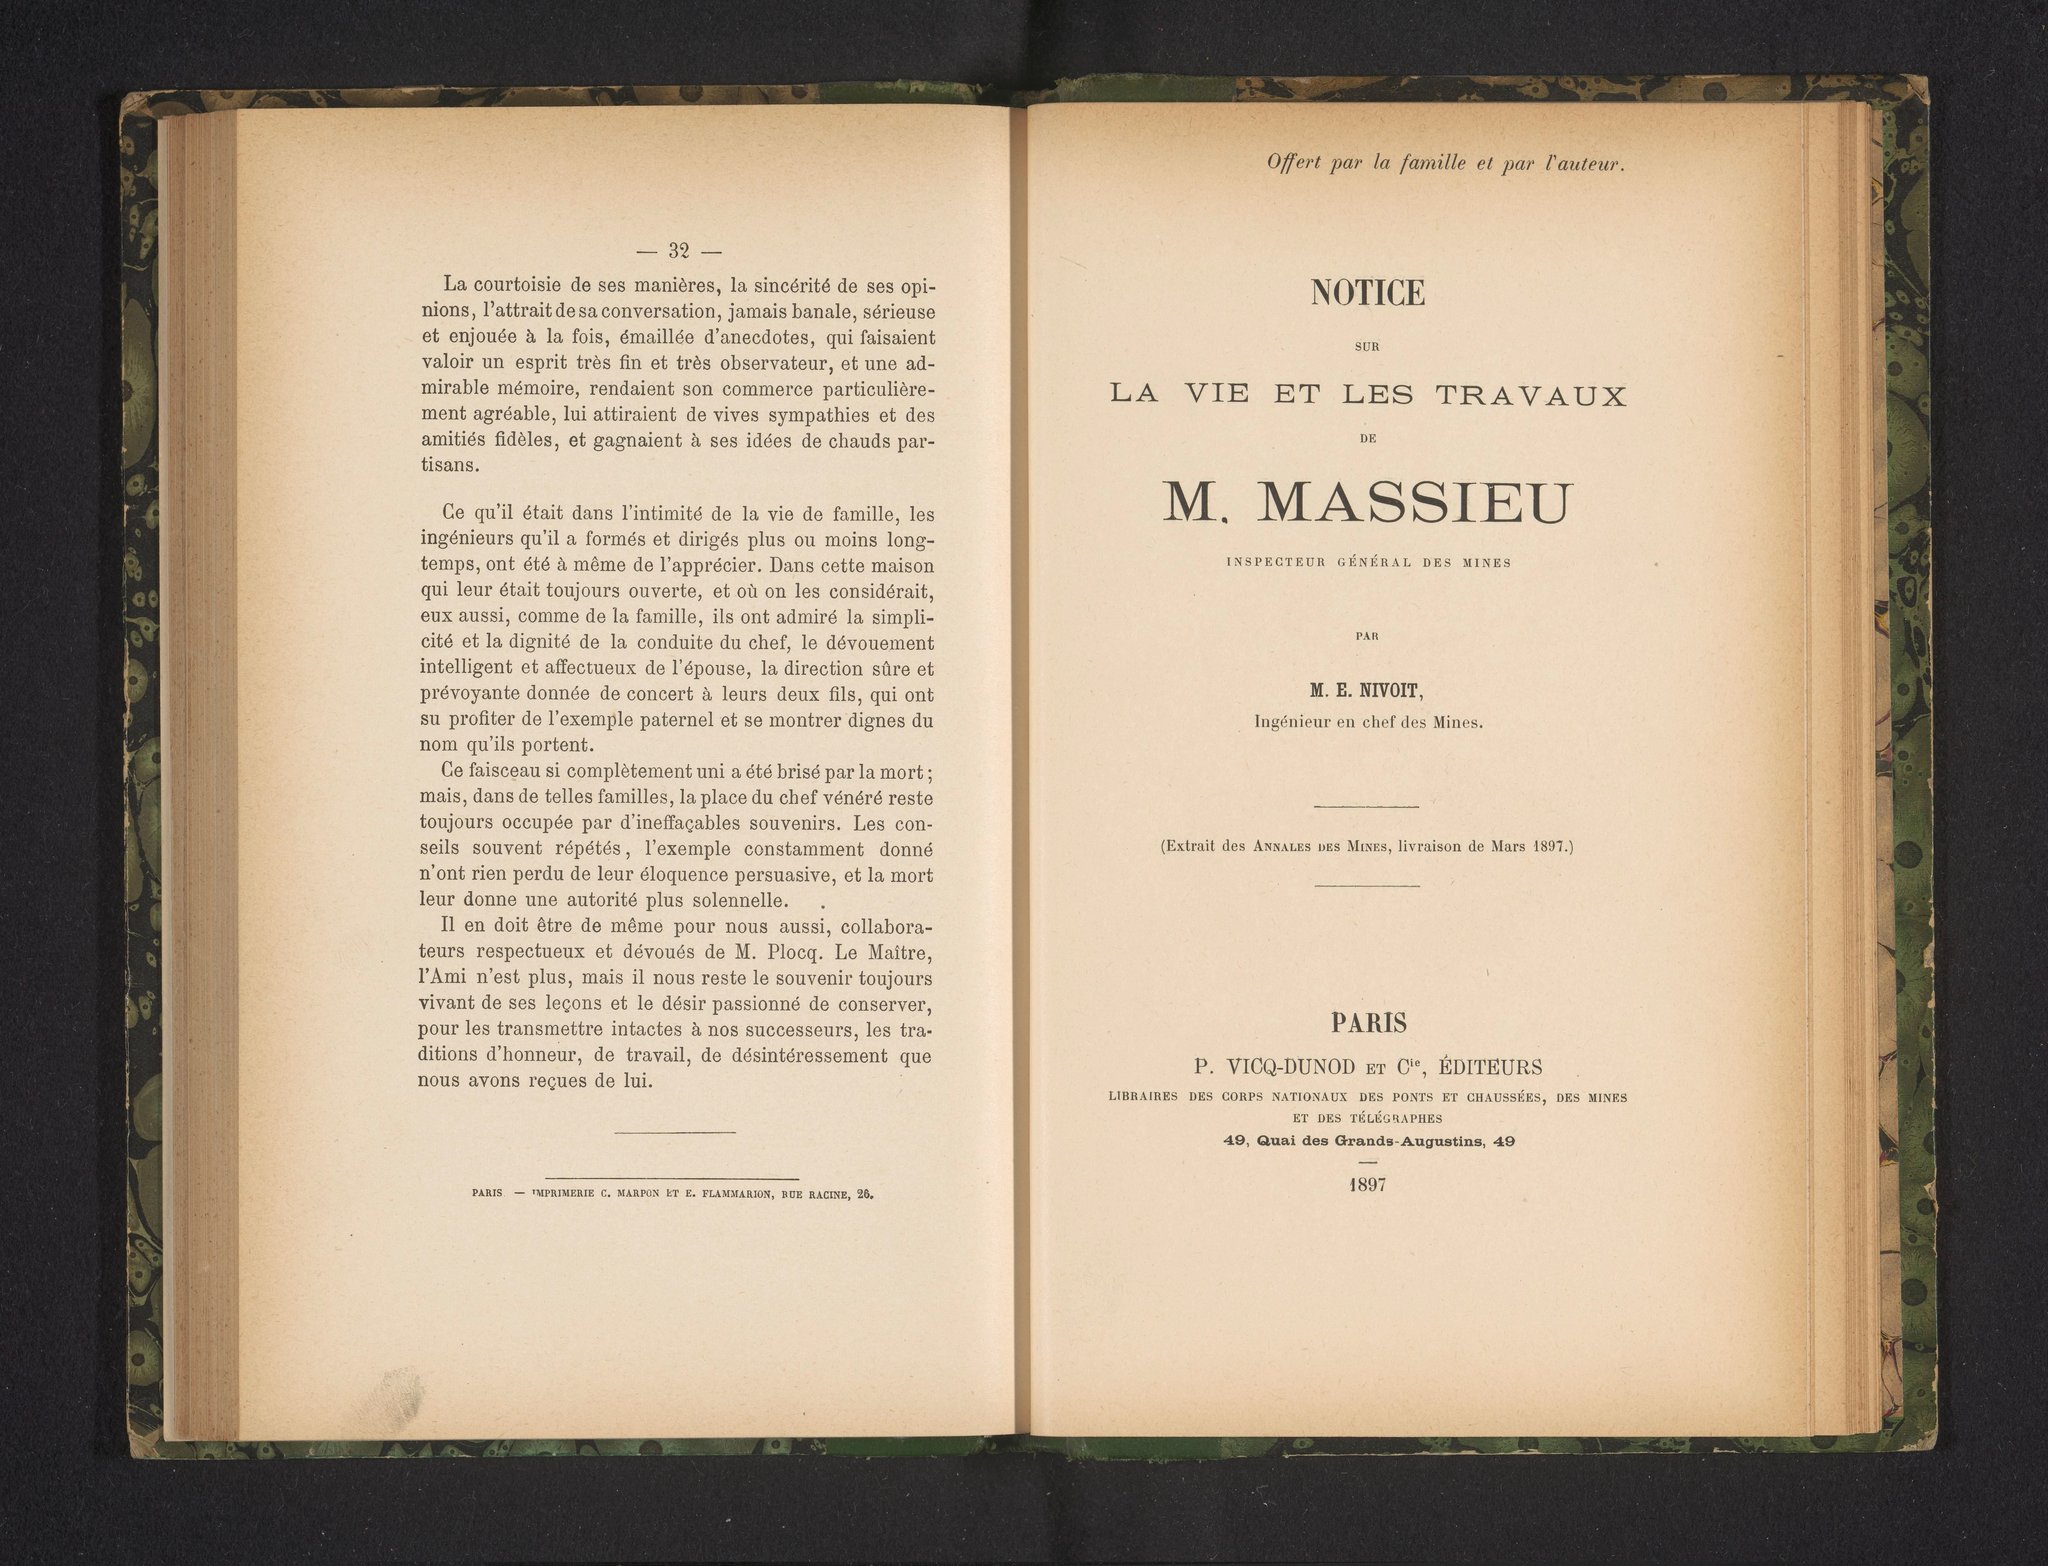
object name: book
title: Notice sur la vie et les travaux de M. Massieu, inspecteur général des mines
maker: edmond nivoit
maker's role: engineer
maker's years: 1839-1920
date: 1897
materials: linen, paper, photographic support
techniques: photoaquatint, printing, marbled paper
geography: paris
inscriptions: annotation: ‘ex-W. [...]/ 1993’